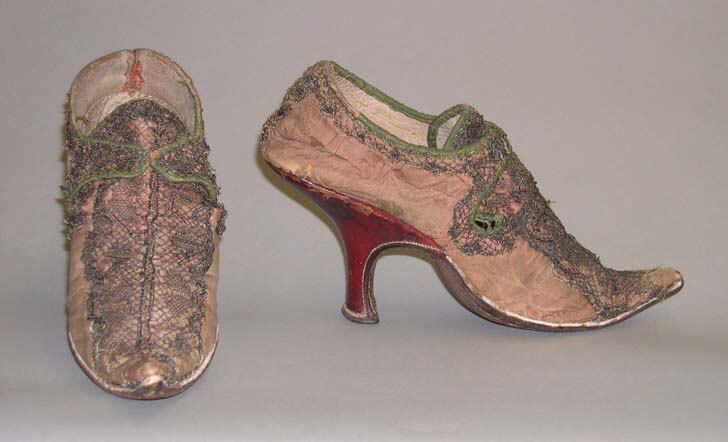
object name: slipper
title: Slippers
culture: french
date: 1720-1739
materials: leather, silk